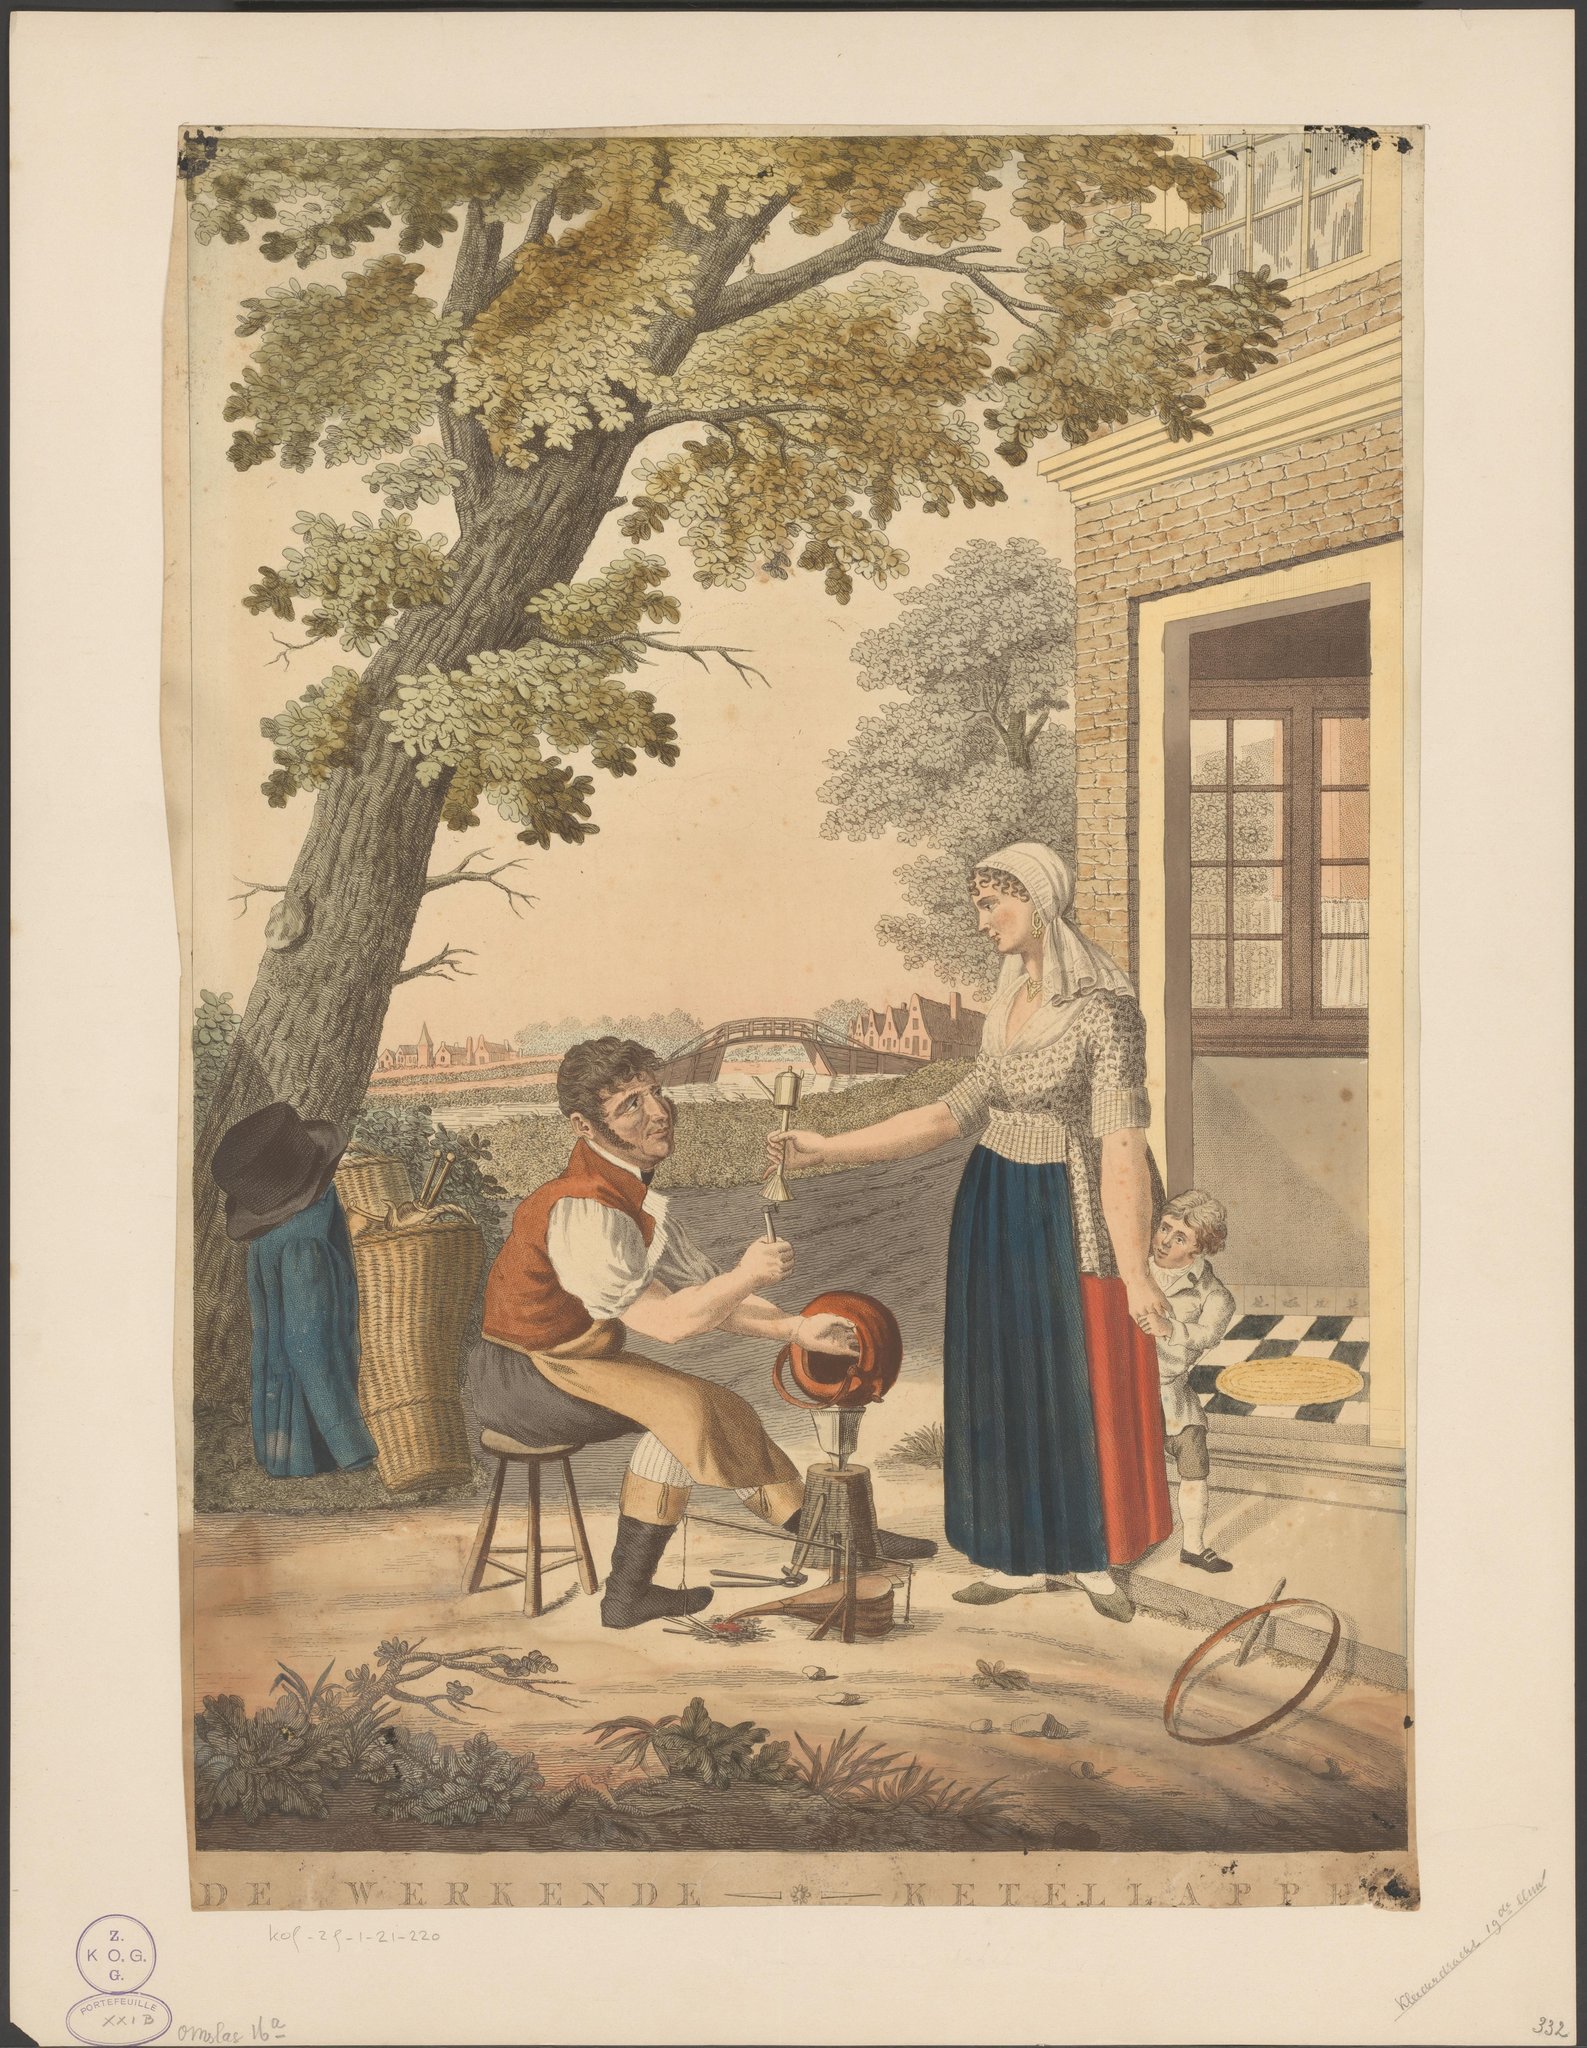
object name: print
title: De werkende ketellapper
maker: Anonymous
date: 1800-1849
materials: paper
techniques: etching, hand coloring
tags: mother and son(s) (family group), handicrafts, craftsman at work, 'en route', traveller under way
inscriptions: stamp, collector's mark: Lugt 1641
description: Een reizende ketellapper is buiten aan het werk. Een vrouw met kind staat bij hem een houdt hem een olielamp voor. Achter haar verschuil een kind zich. Onderwerpsrubrieken binnen de Atlas Zeden en Gewoonten: Zeden en Gewoonten in Engeren Zin, De Kleeding, Kleederdrachten (tijdvakken), Het begin der 19de eeuw. Mannen en vrouwen.